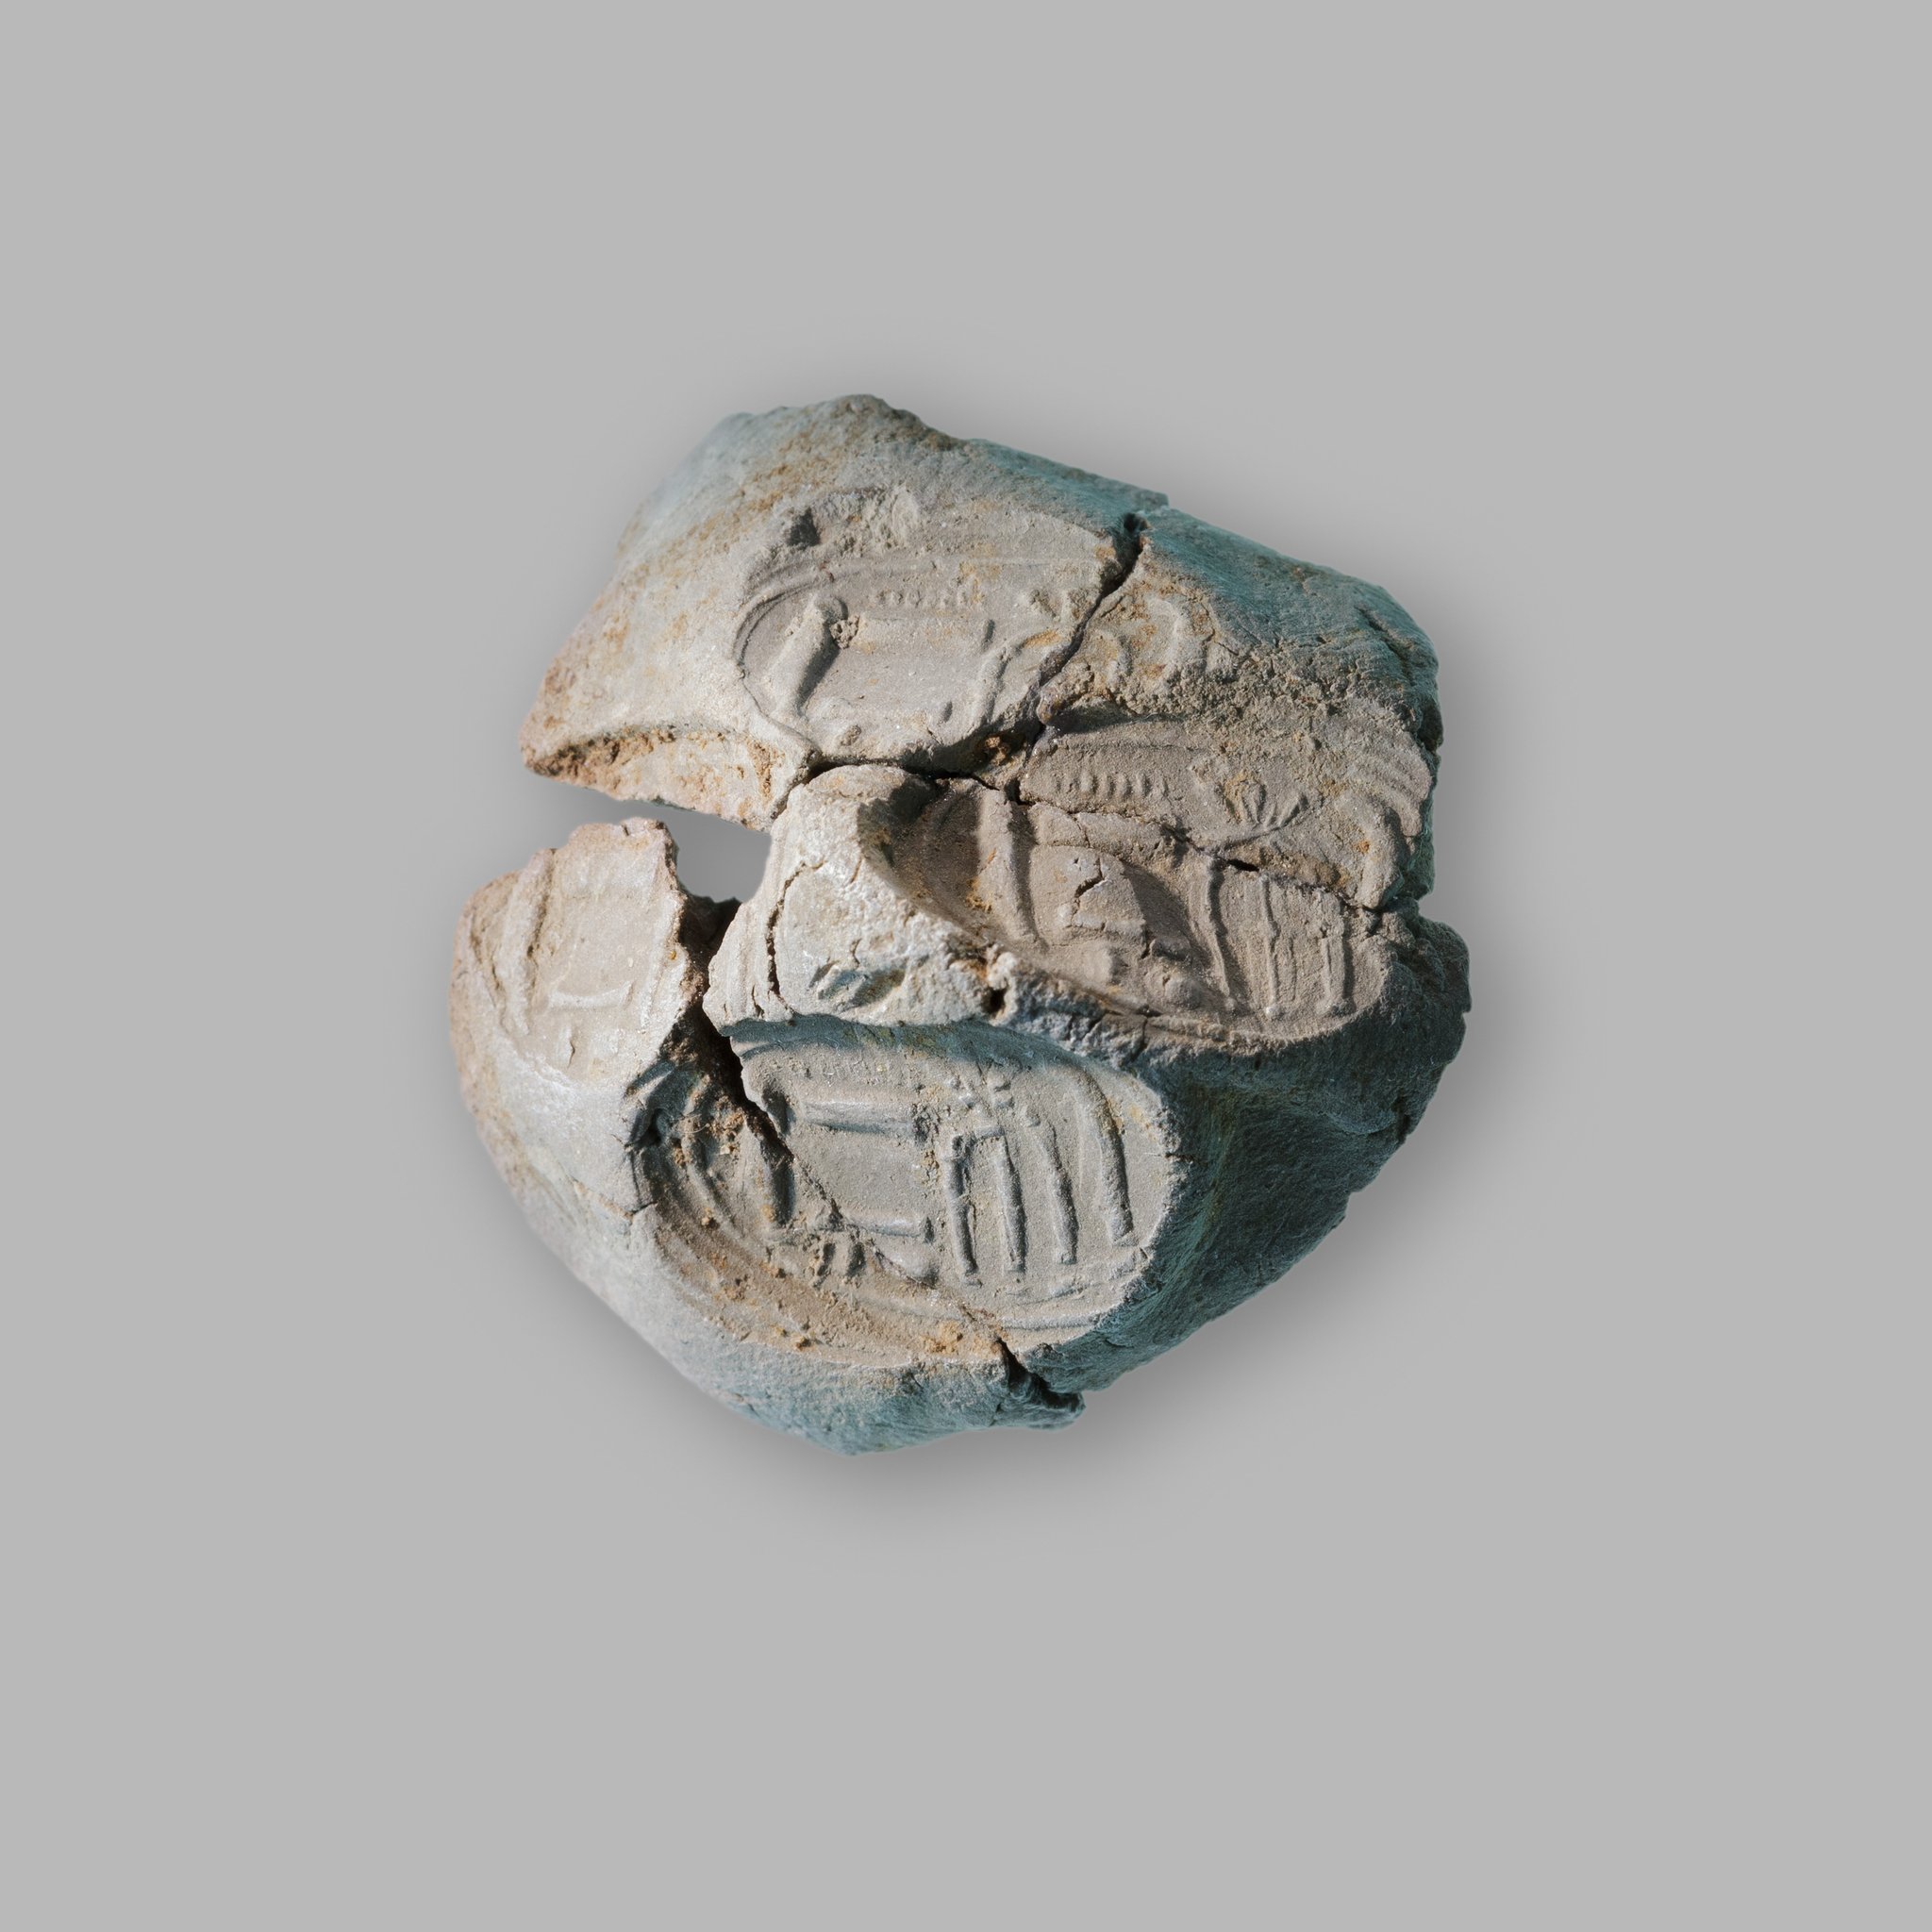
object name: sealing, amun re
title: Document Sealing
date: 1390-1352 BCE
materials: mud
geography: egypt